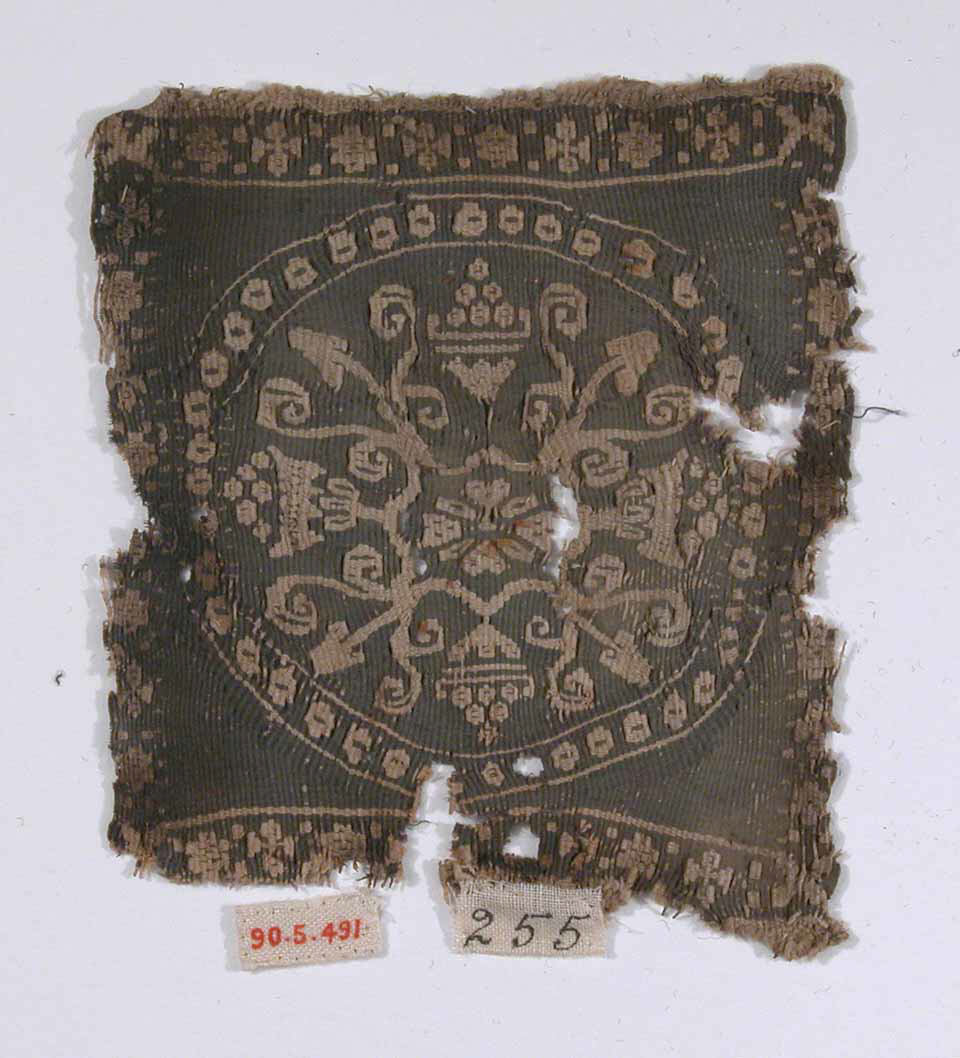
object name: textile fragment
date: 301-400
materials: linen, wool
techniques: weave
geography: egypt